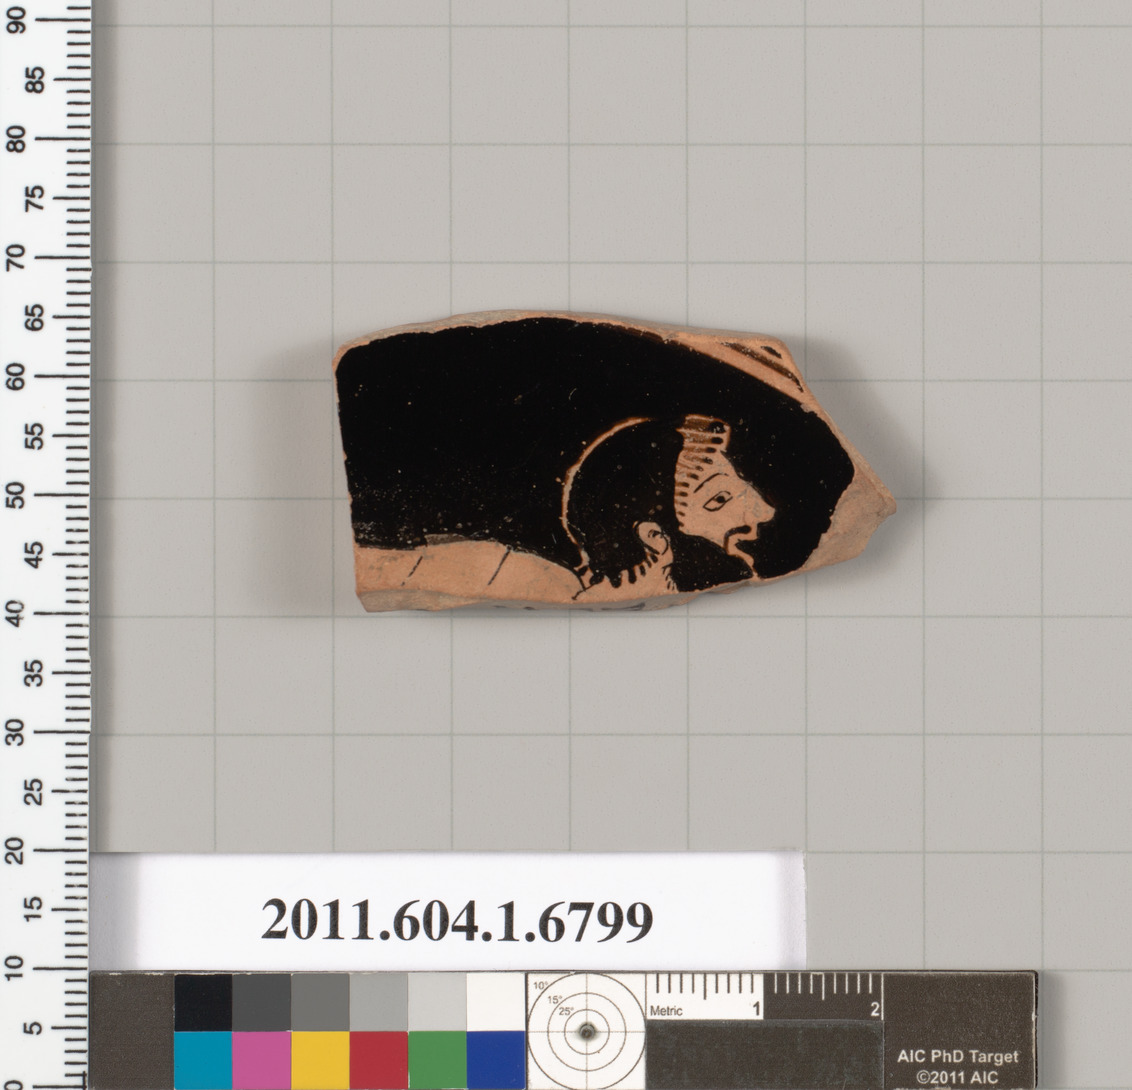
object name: kylix fragment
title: Terracotta fragment of a kylix (drinking cup)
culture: greek, attic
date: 490-470 BCE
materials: terracotta